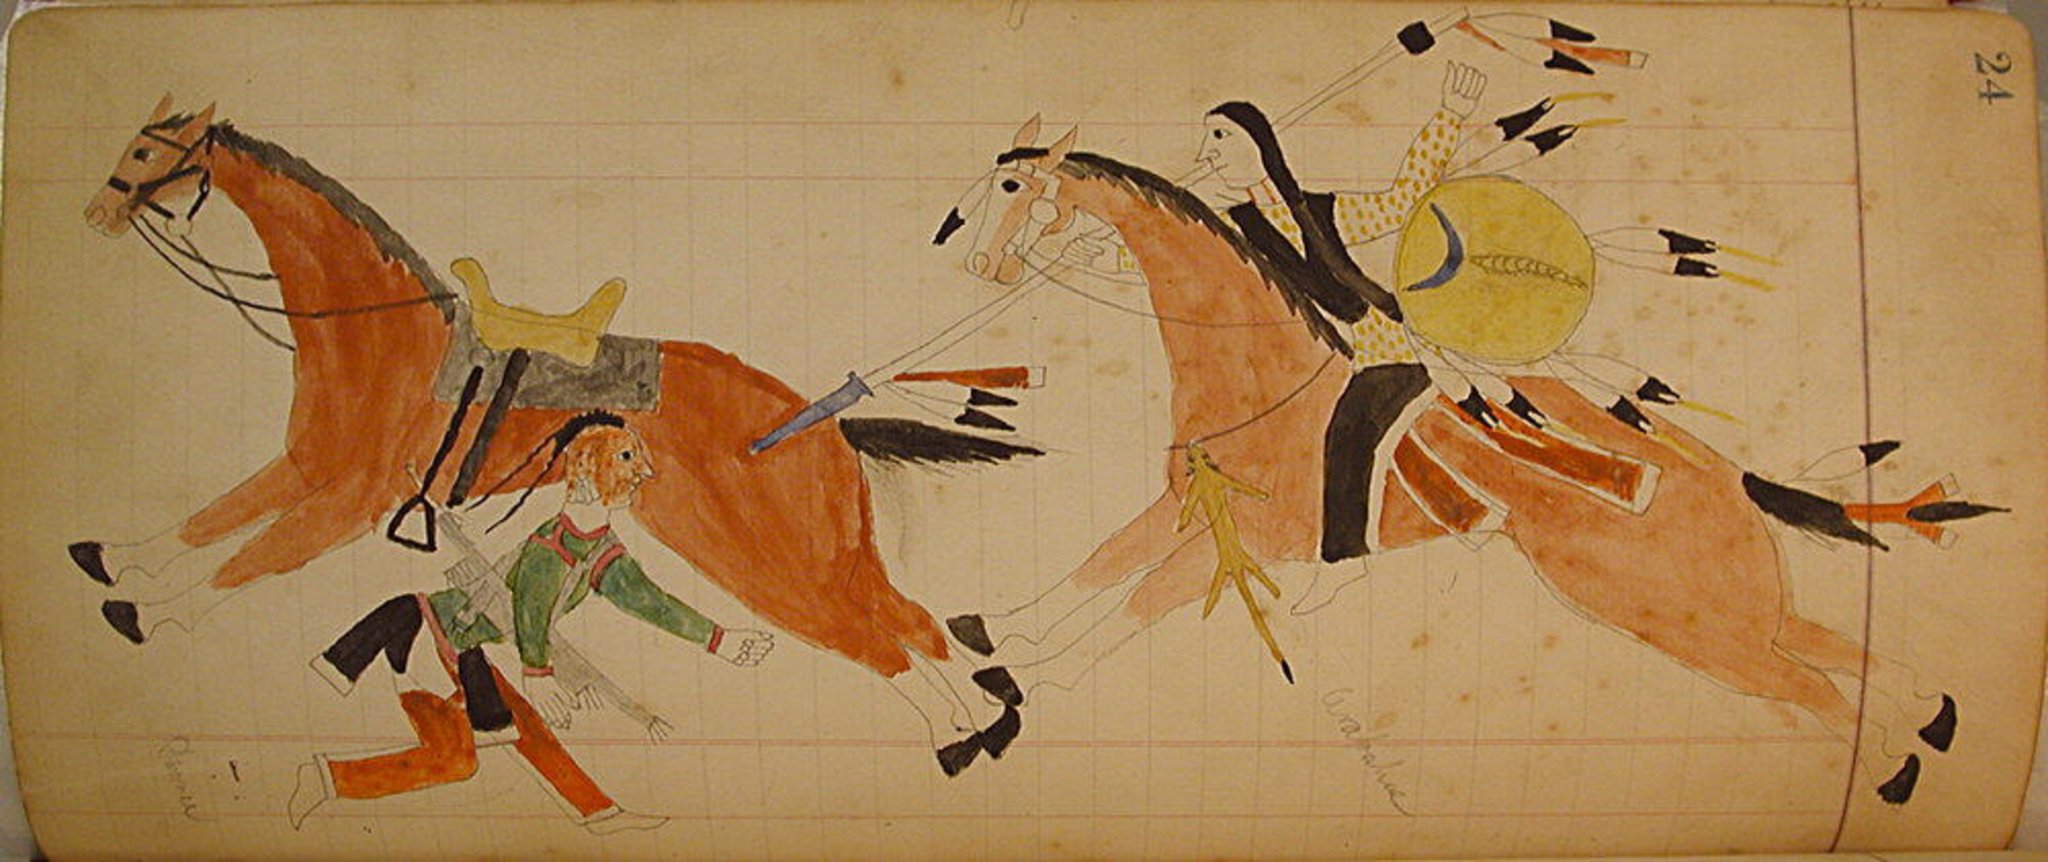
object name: drawing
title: Maffet Ledger: Two Indians with horses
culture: cheyenne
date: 1874-1881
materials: crayon, graphite, paper, watercolor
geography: united states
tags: men,horses